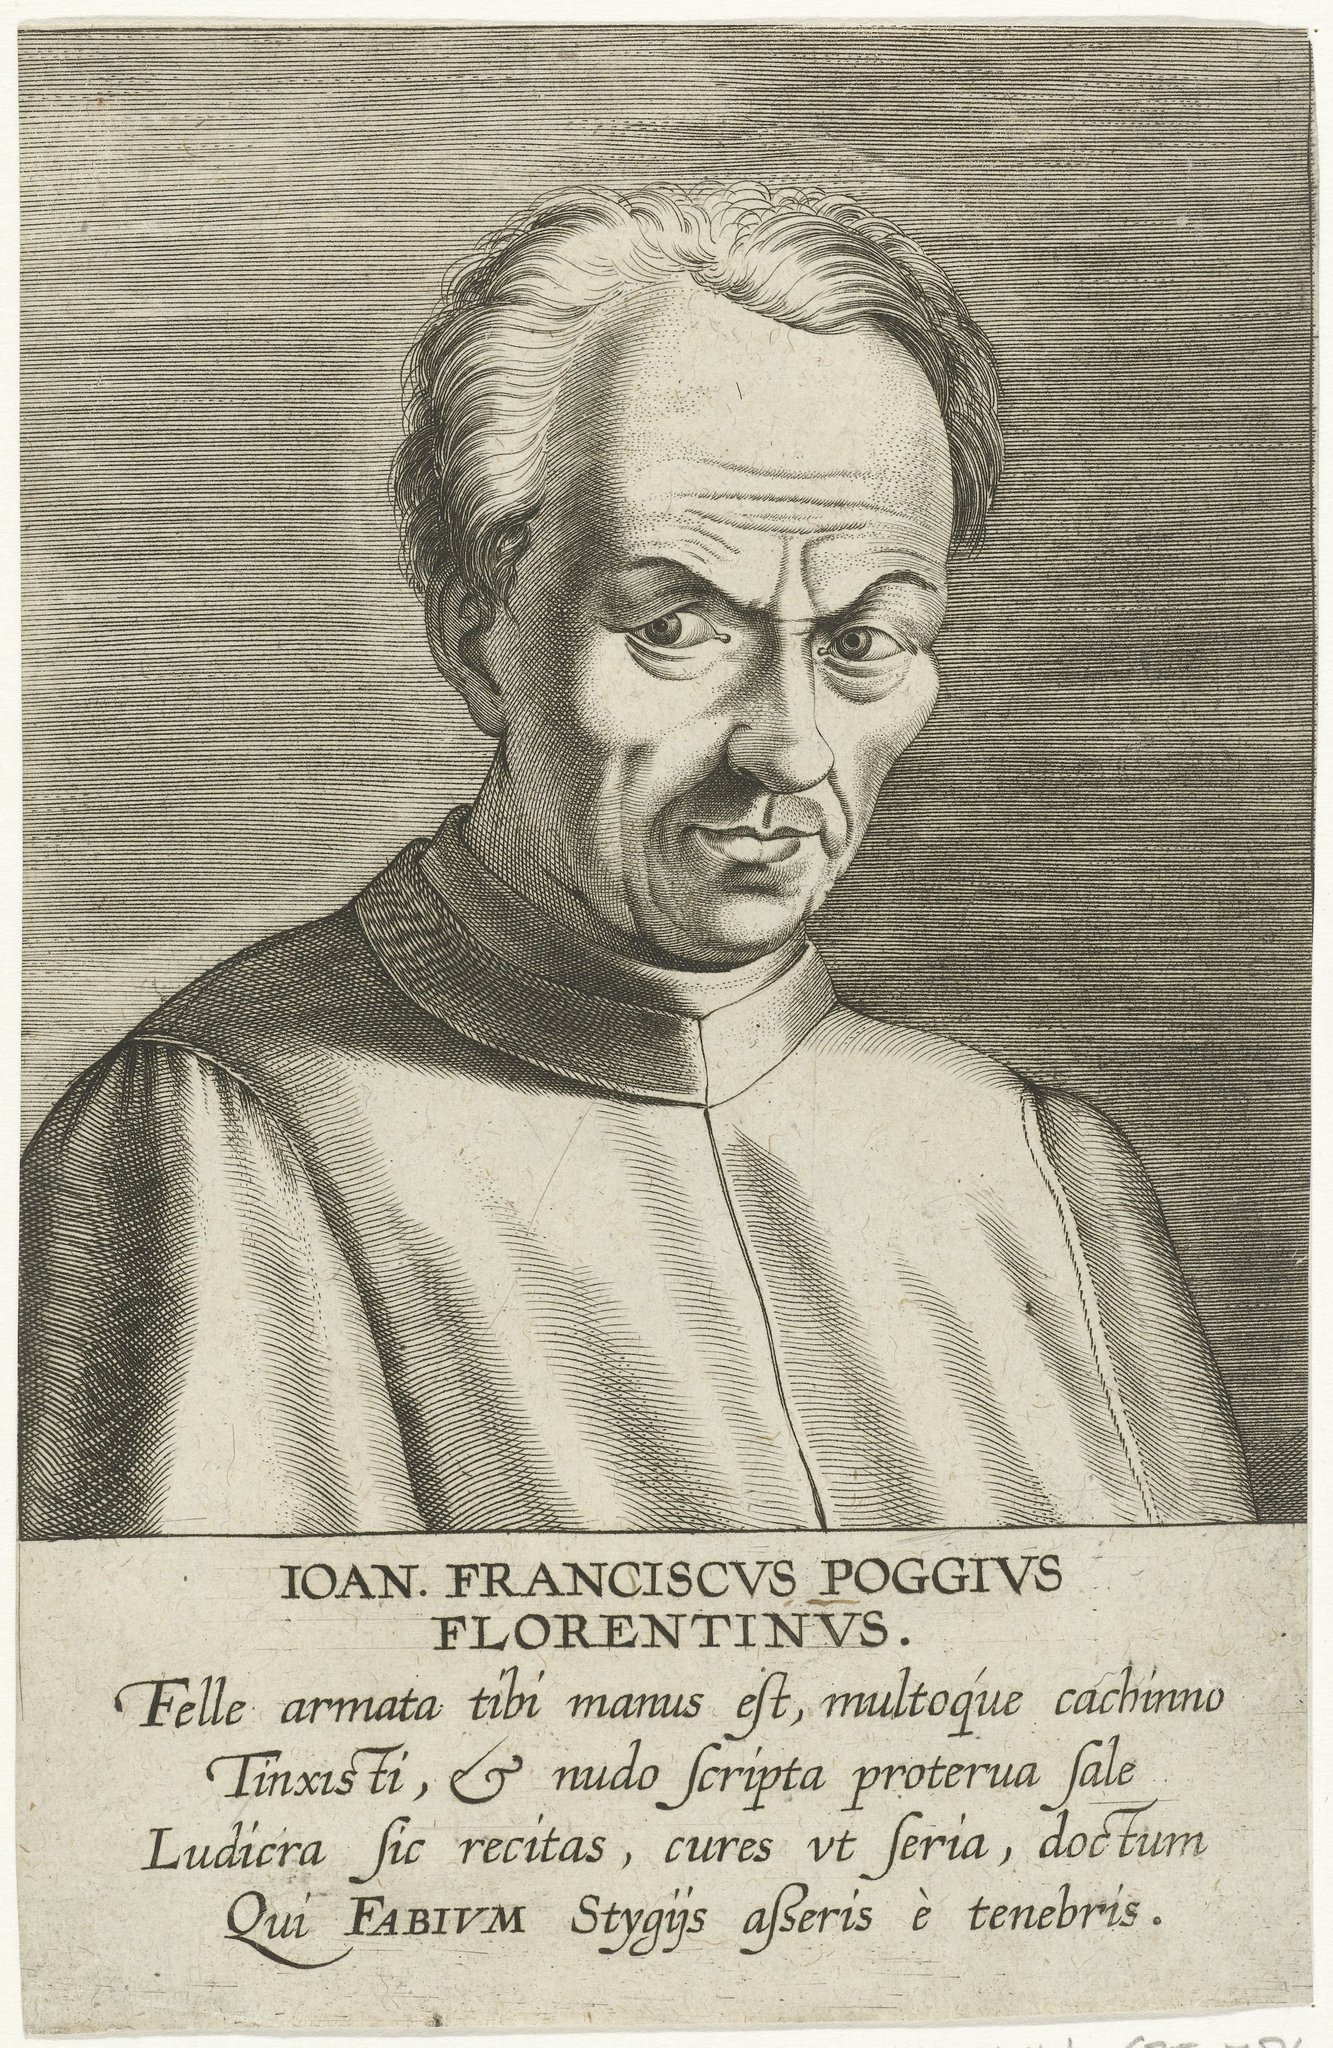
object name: print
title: Italorum Doctrina Illustrium imagines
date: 1600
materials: paper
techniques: engraving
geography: antwerp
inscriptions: collector's mark: Lugt 2228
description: Portret van Gian Francesco Poggio Bracciolini, een Florentijns historicus. Buste naar rechts. De prent heeft een Latijns onderschrift en maakt deel uit van een serie met portretten van beroemde Italiaanse geleerden.